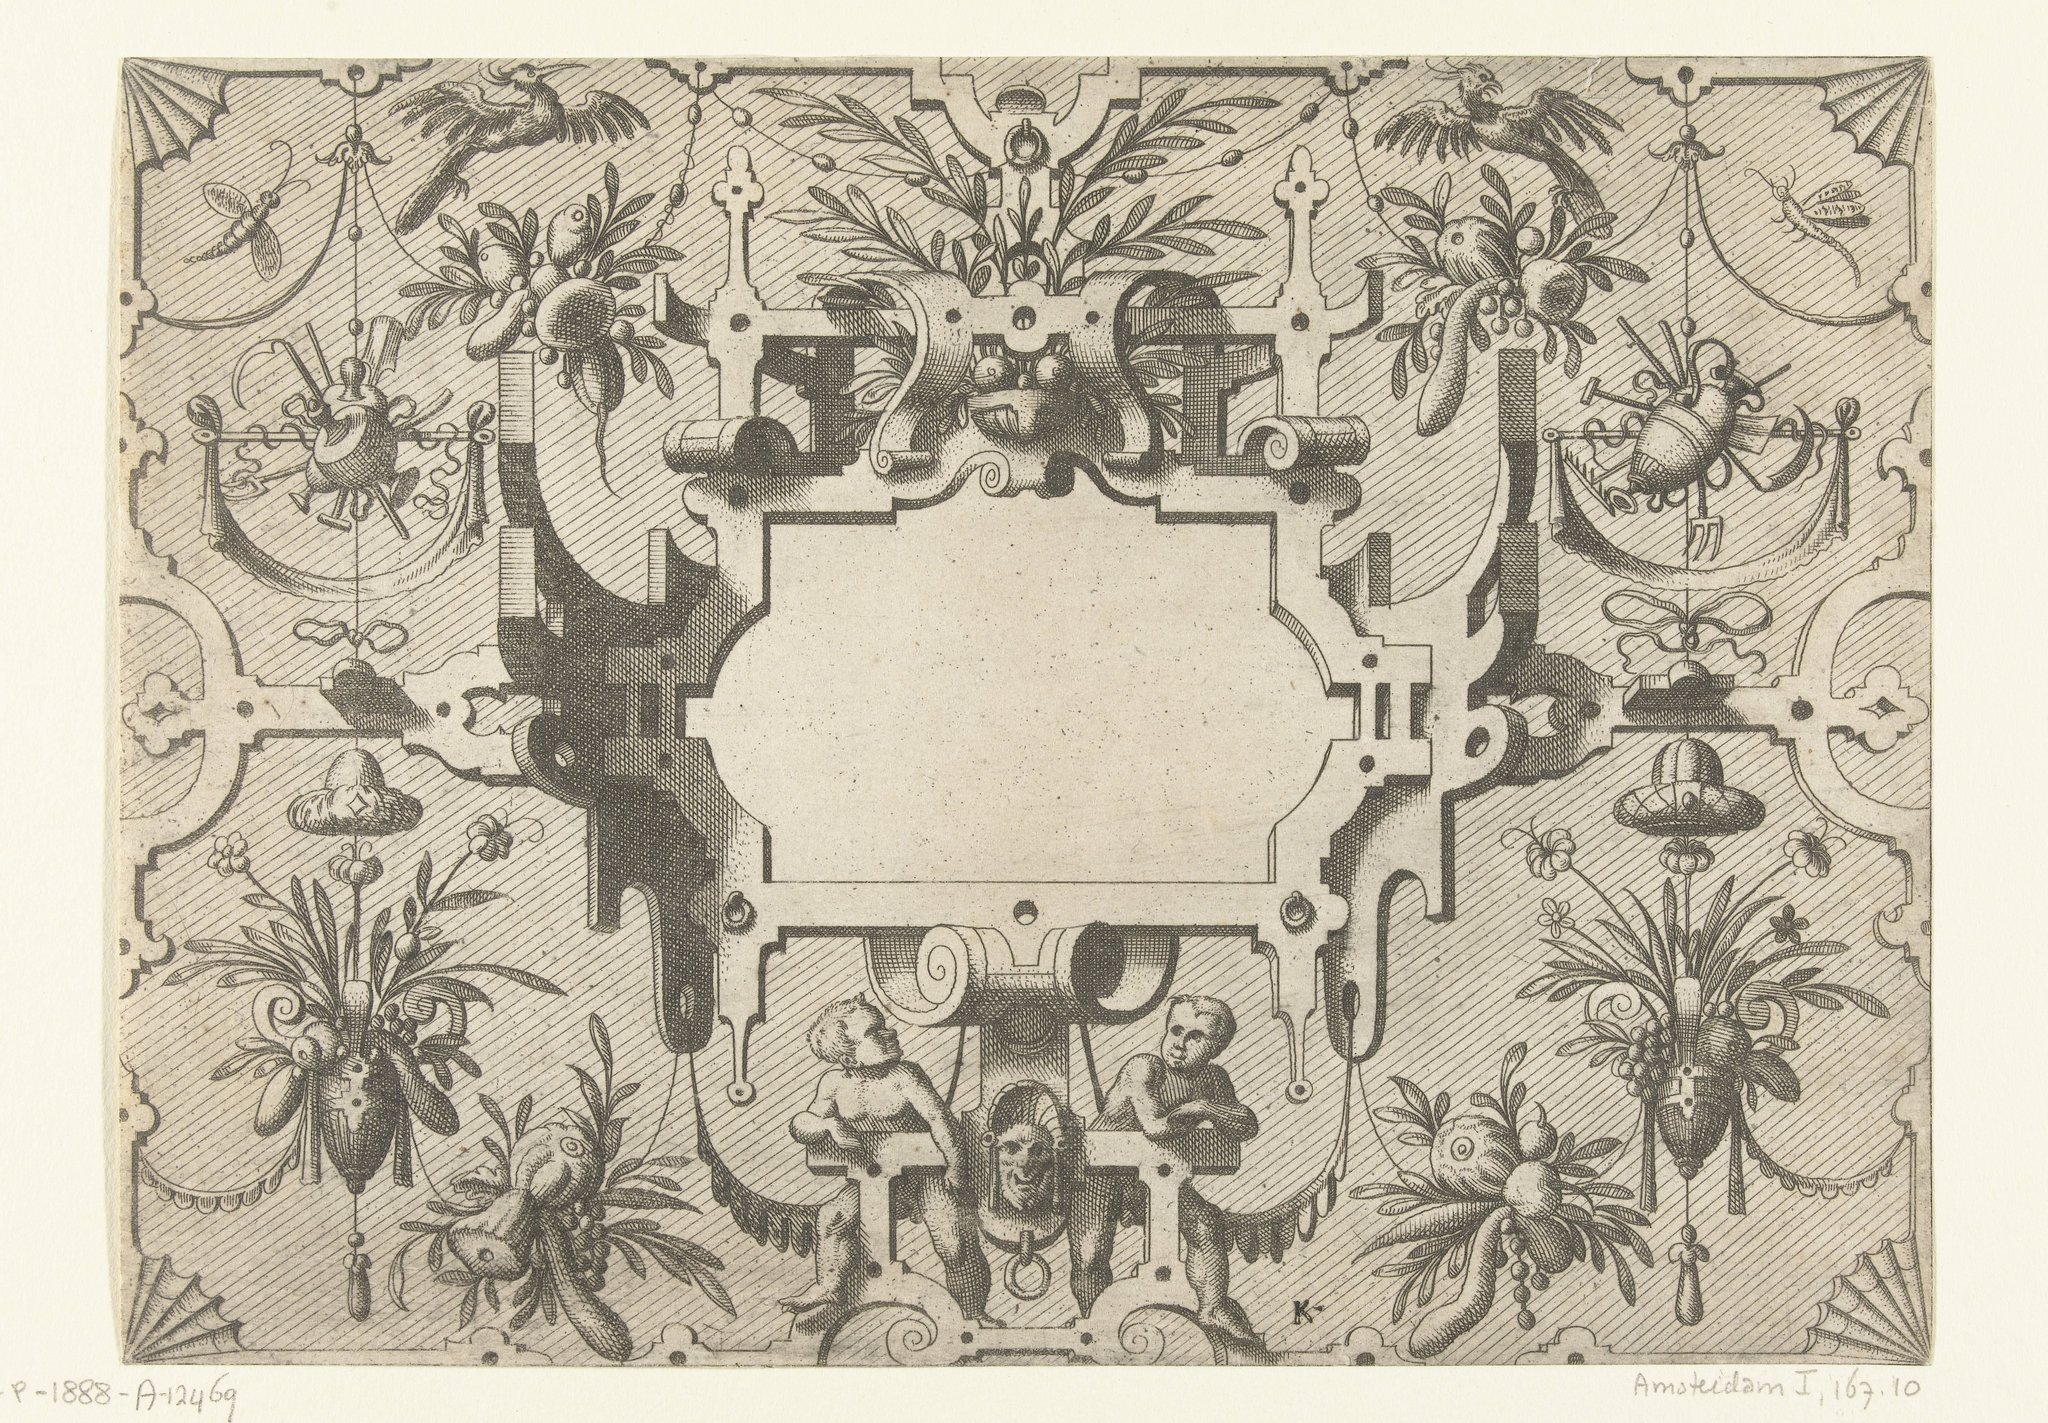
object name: print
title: Cartouche omgeven door grotesken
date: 1555-1560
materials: paper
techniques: etching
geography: netherlands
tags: ornament ~ grotesque, ornament ~ cartouche, ornament ~ festoon, garland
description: Onderaan leunen twee jongetjes over een rolwerk. Om de cartouche heen hangen trofeeën en guirlandes met vruchtentrossen. Linksboven en rechtsboven vliegen een vogel en een insect. Blad K uit serie van 16 bladen, geletterd A-Q. Gearceerde of gestippelde achtergrond.